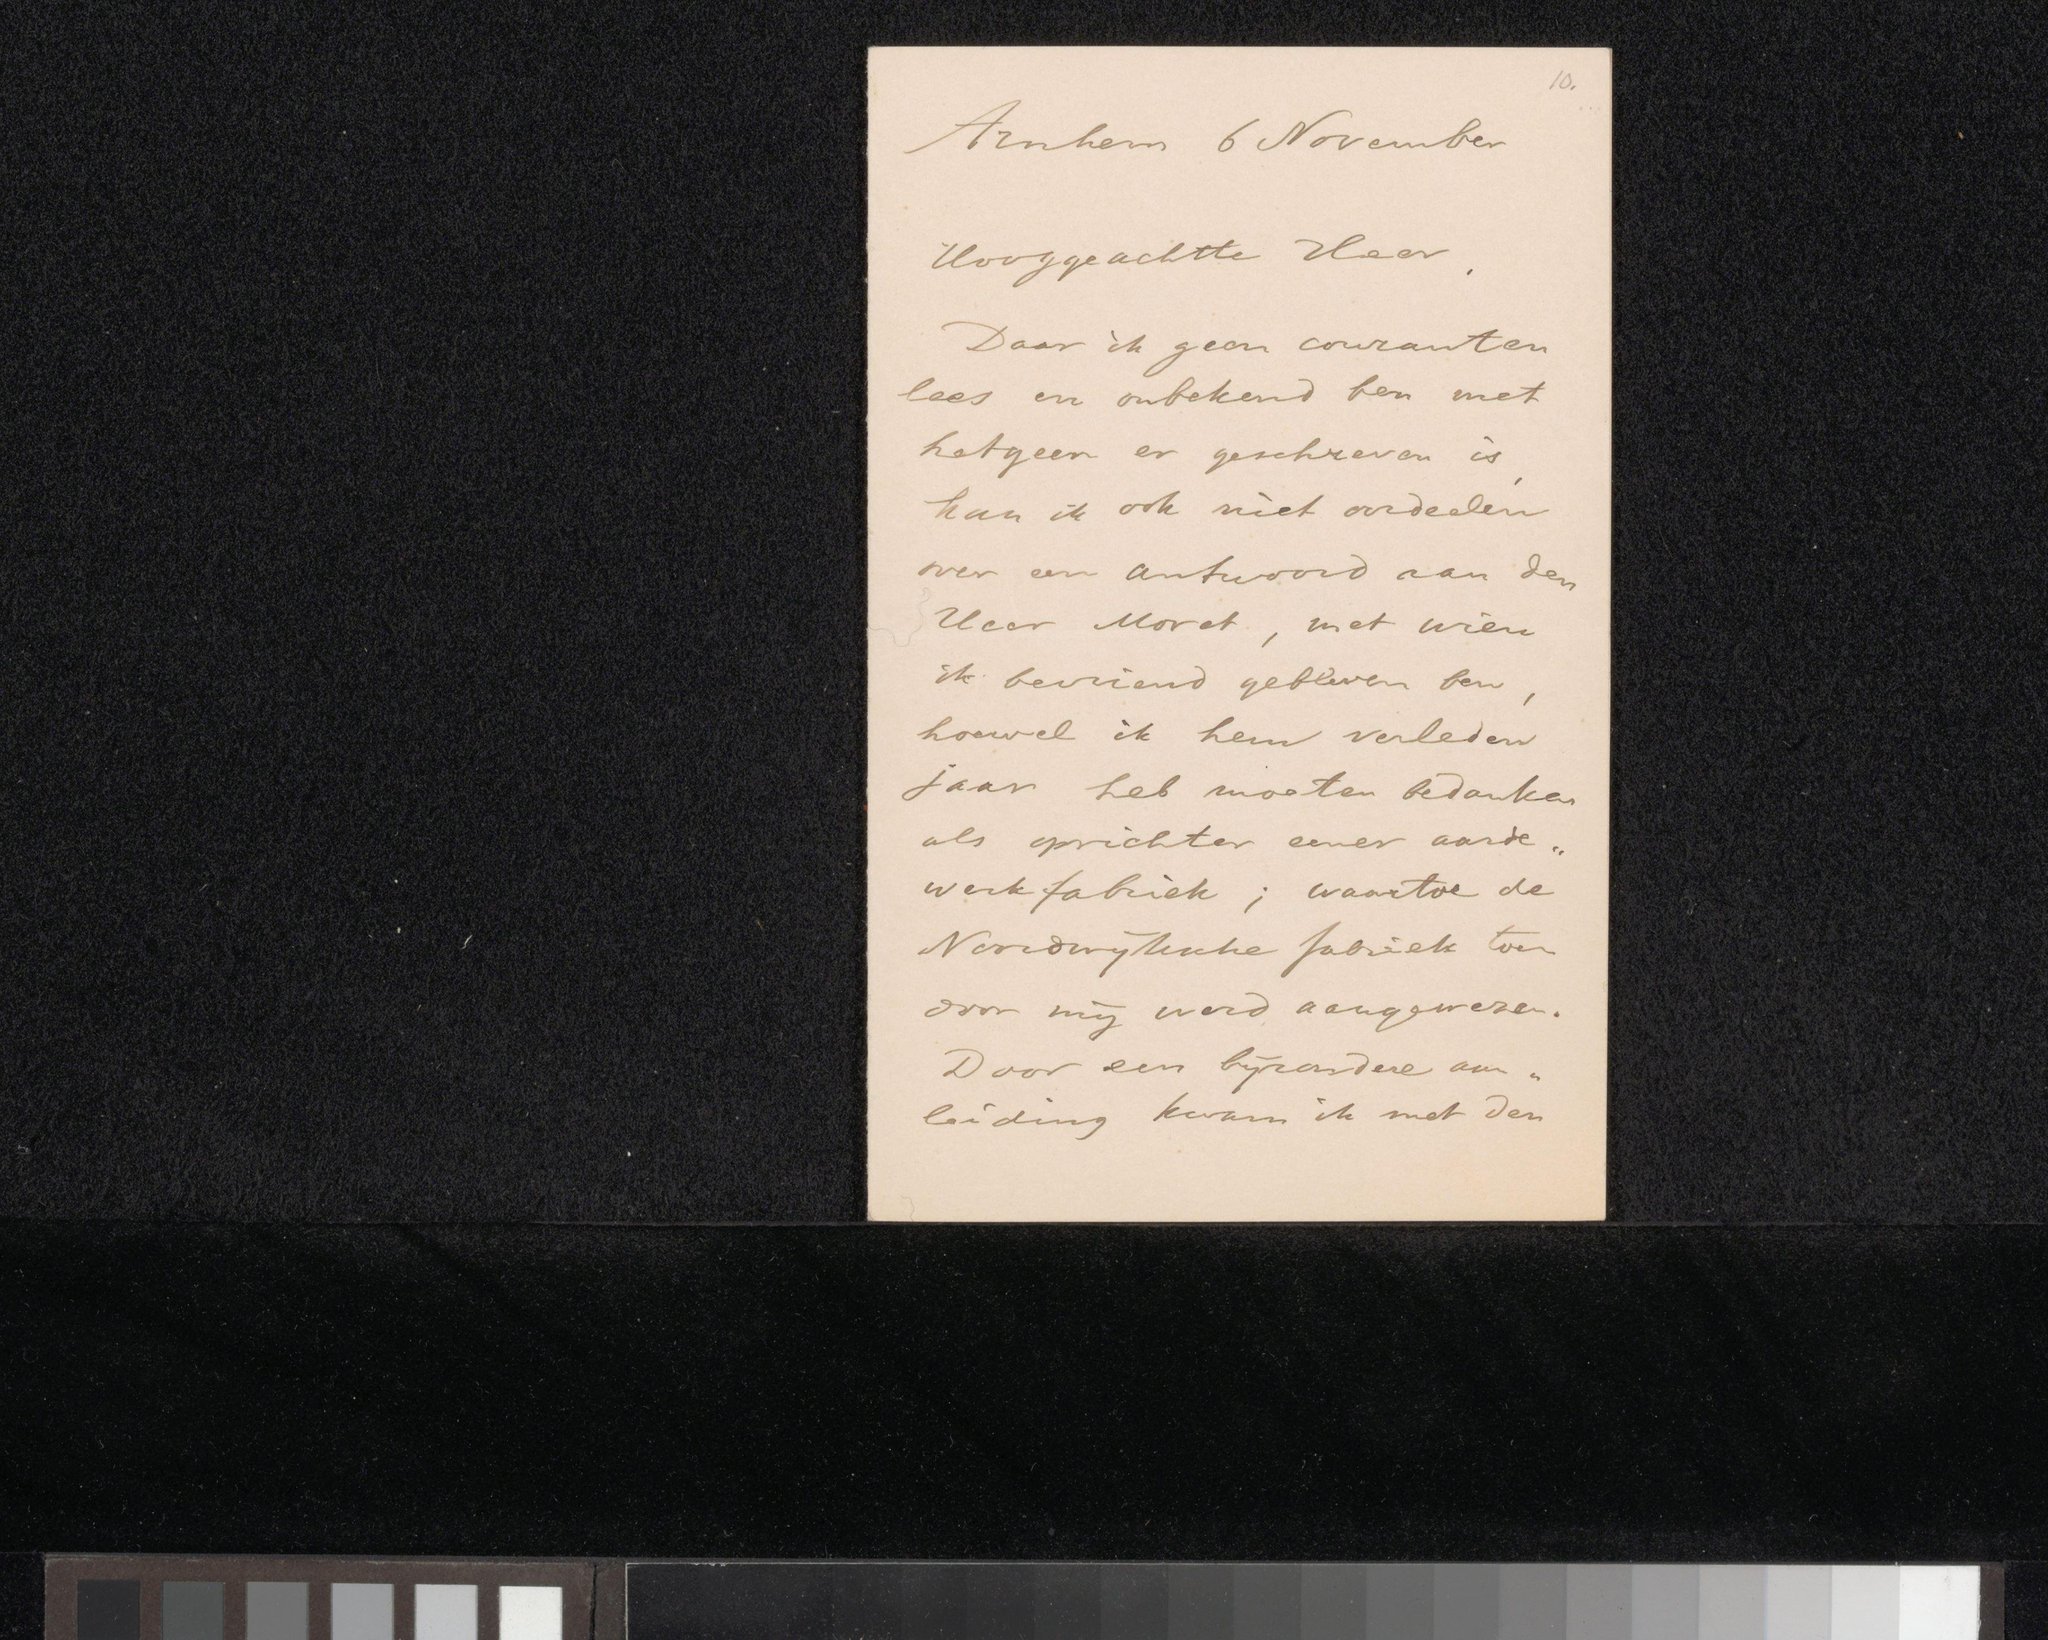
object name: letter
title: Brief aan Pieter Haverkorn van Rijsewijk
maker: theo colenbrander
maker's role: draughtsman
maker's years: 1841-1930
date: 1911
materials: ink, paper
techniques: pen, writing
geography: arnhem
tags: w.g. eberson, pieter haverkorn van rijsewijk, applied arts, arts and crafts; industrial design, money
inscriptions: collector's mark: ‘RPK’